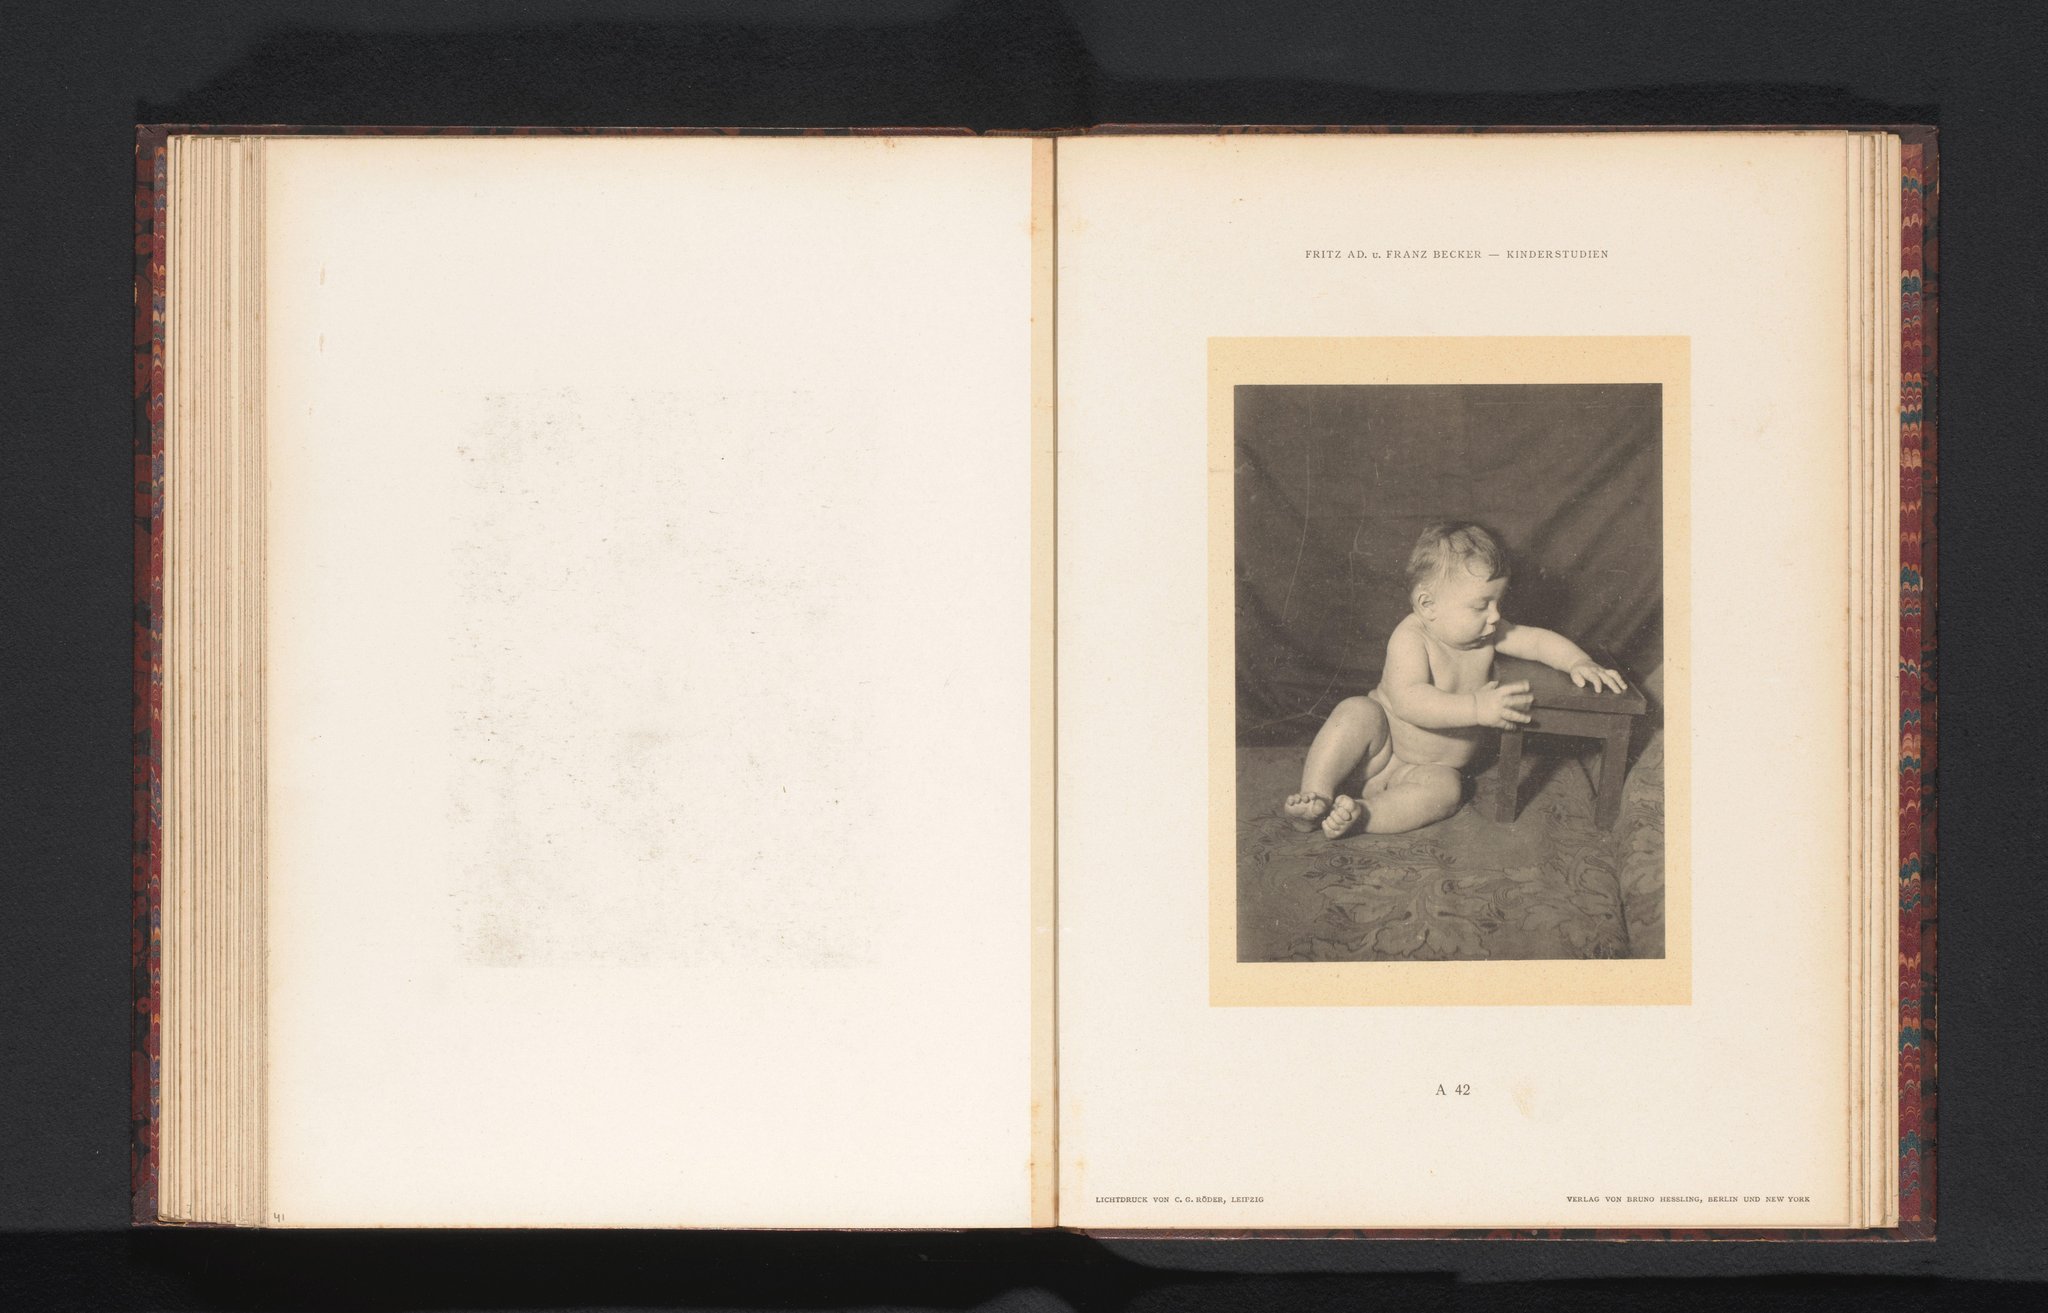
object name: page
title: Zittende naakte jongen met een kruk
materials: paper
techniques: photograph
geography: leipzig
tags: toddler (male), stool, sitting on the ground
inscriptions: number: ‘A 42’